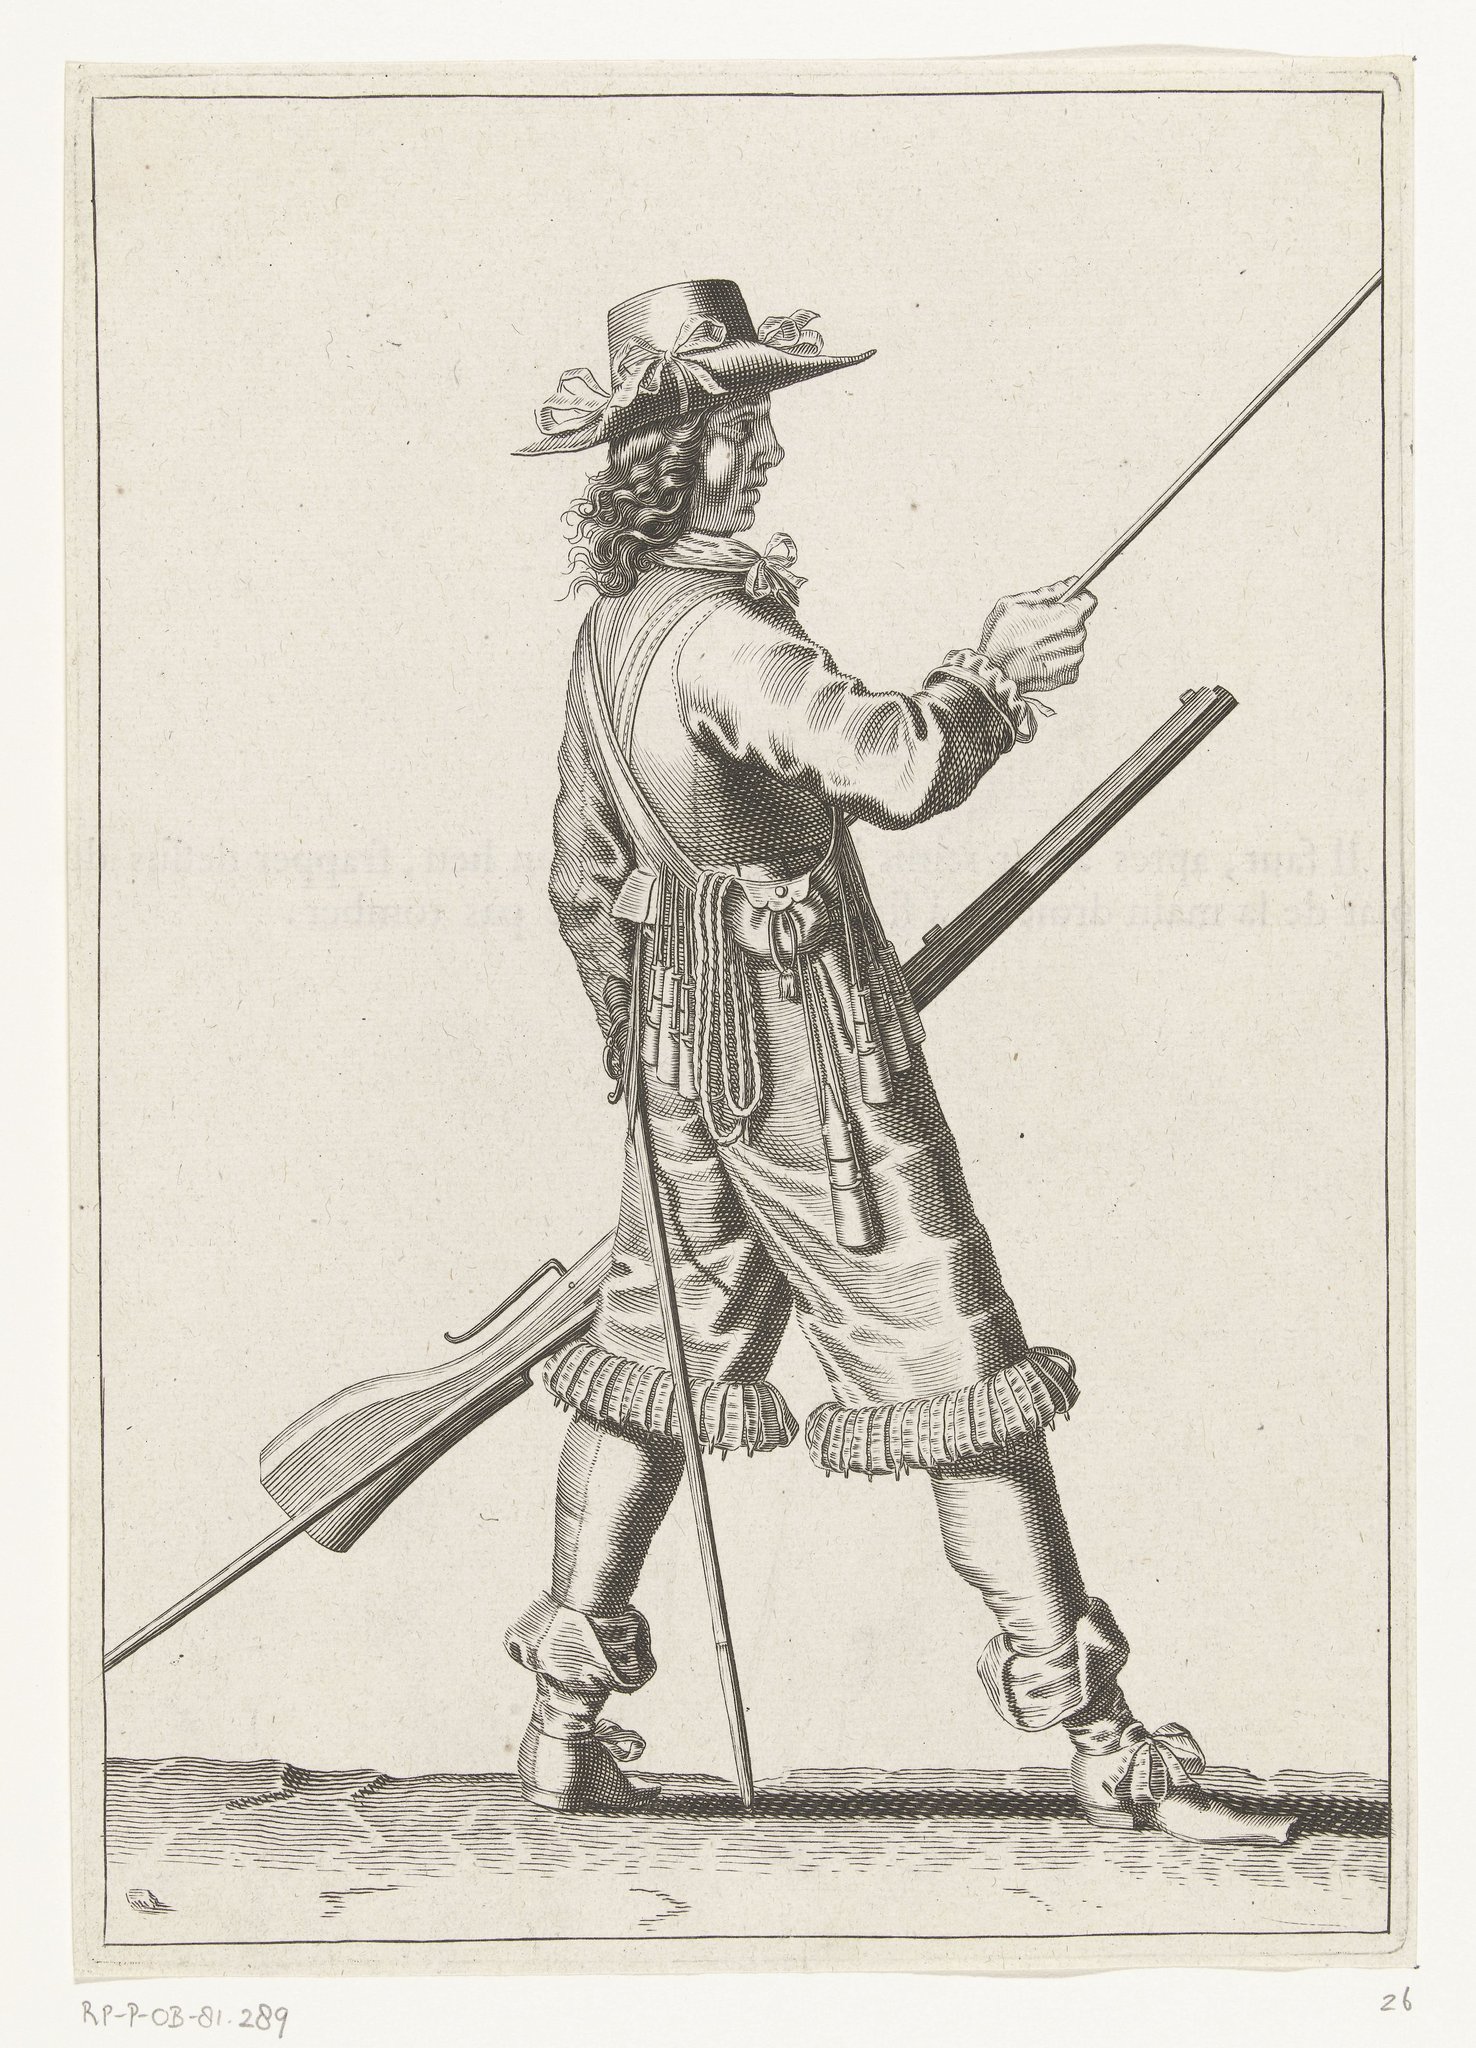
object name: print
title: Soldaat met een musket die zijn rechterhand naar het uiteinde van zijn laadstok schuift, ca. 1645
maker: petrus rucholle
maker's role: print maker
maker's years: 1618-1647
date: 1645-1647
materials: paper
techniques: engraving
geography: southern netherlands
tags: handling of weapons ~ military training, weapons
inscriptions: annotation: ‘Frappez la baguette contre l'esternace p. 57’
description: Een soldaat, ten voeten uit, naar rechts, die met zijn linkerhand bij zijn linkerdijbeen een musket (een bepaald type vuurwapen) vasthoudt en zijn rechterhand naar het uiteinde brengt van zijn laadstok, die hij tegen zijn rechterzij laat steunen. In zijn linkerhand behalve het musket ook een lont; aan zijn linkerpols een furket (musketvork). Bedrukt op achterzijde met tekst in het Frans. Vrije kopie naar plaat 26 in de instructies voor het hanteren van het musket in de Wapenhandelinghe van J. de Gheyn. Krijgswezen rond 1600.